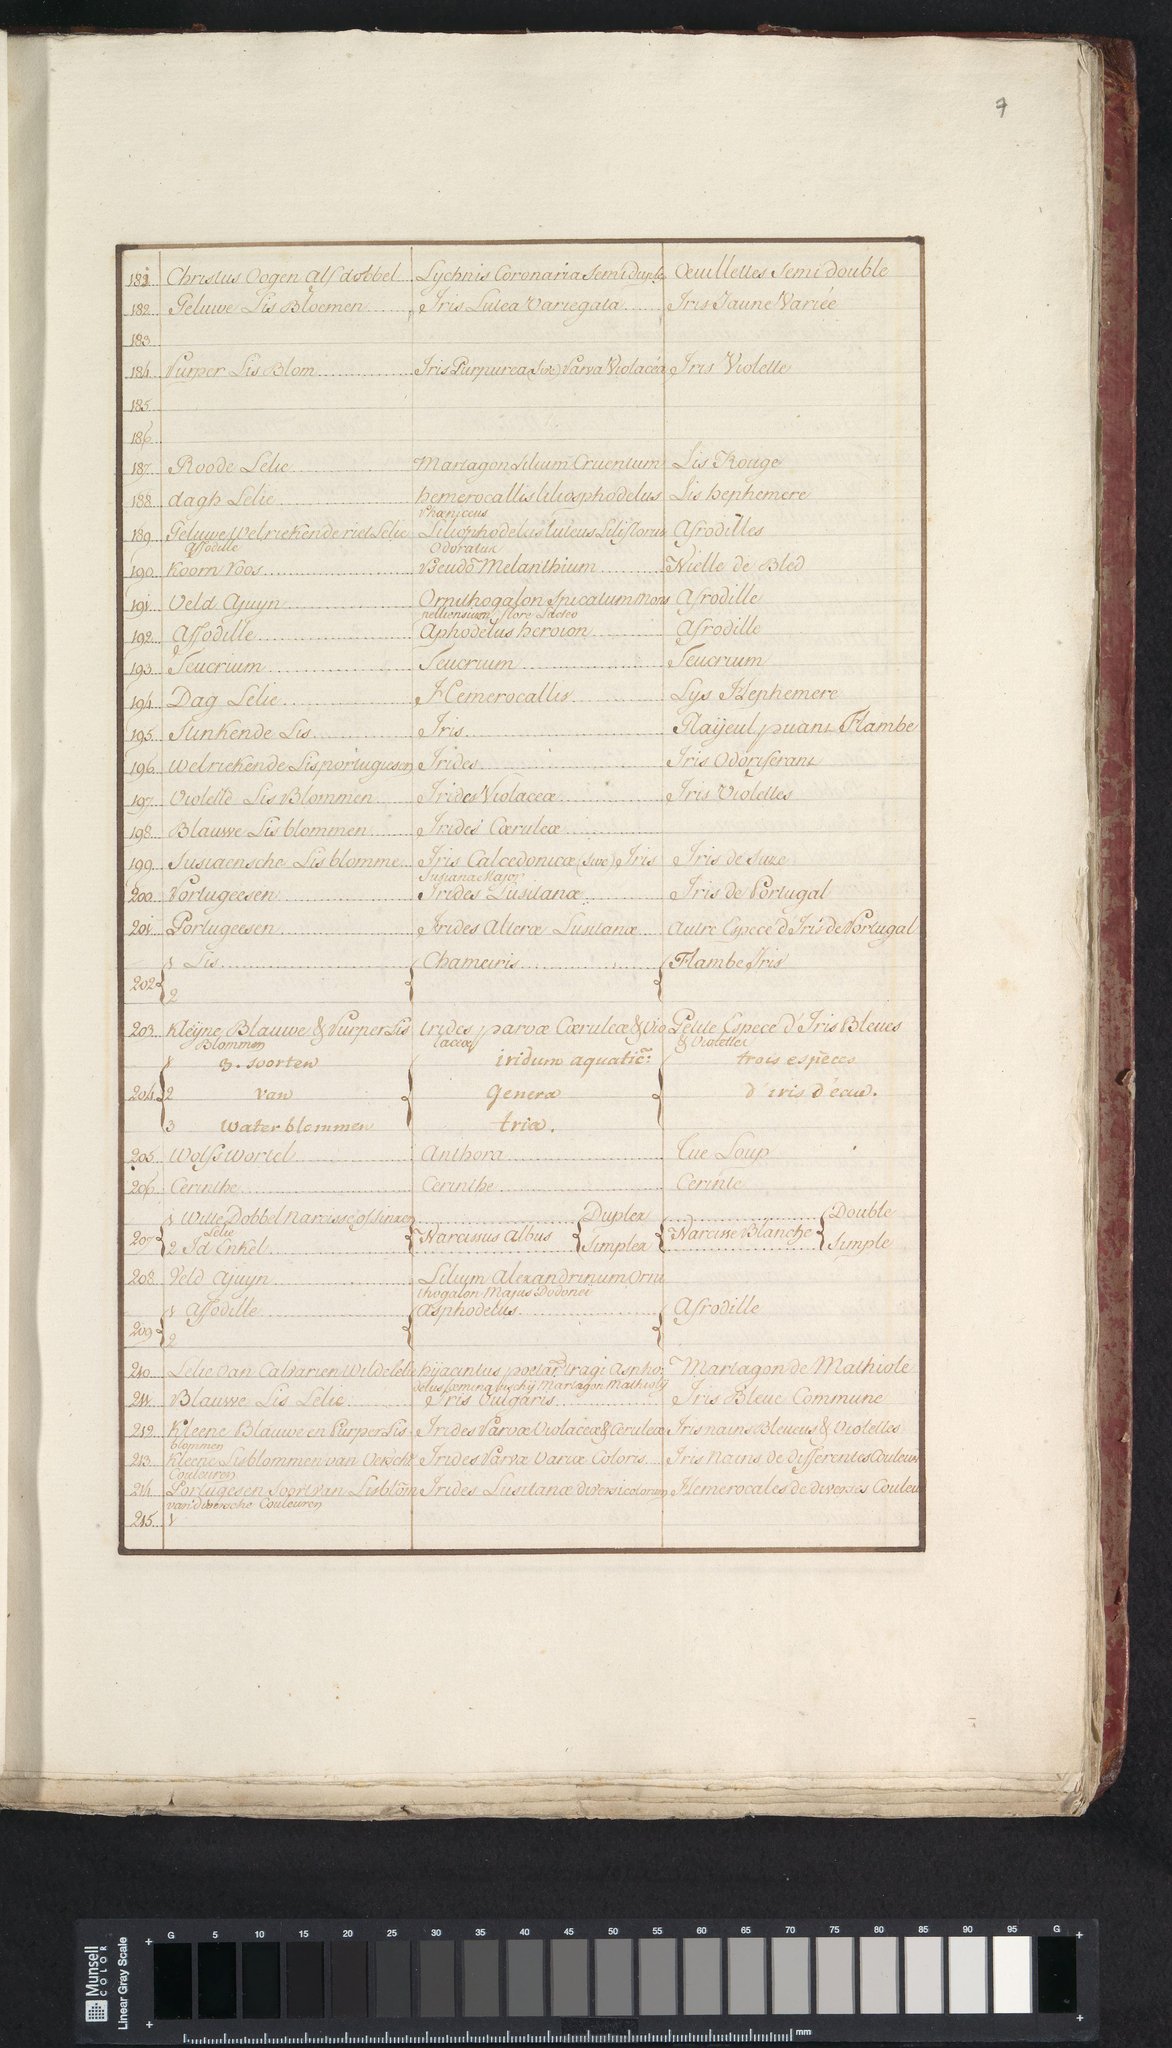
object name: manuscript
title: Lijst van alle bloemen in de vier albums over bloemen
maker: joseph van huerne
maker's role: kunstliefhebber, mecenas, verzamelaar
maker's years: 1752-1844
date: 1809-1814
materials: ink, paper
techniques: handwriting, pen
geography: bruges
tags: handwriting, written text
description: Schema met een lijst van de namen in het Vlaams, Latijn en Frans van de bloemen voorgesteld in de vier delen van de planten: nummers 181-215. Onderdeel van het eerste album met tekeningen van bloemen. Achtste van twaalf albums met tekeningen van dieren, vogels en planten bekend rond 1600, gemaakt in opdracht van keizer Rudolf II. Met toelichting in Nederlands, Latijn en Frans.